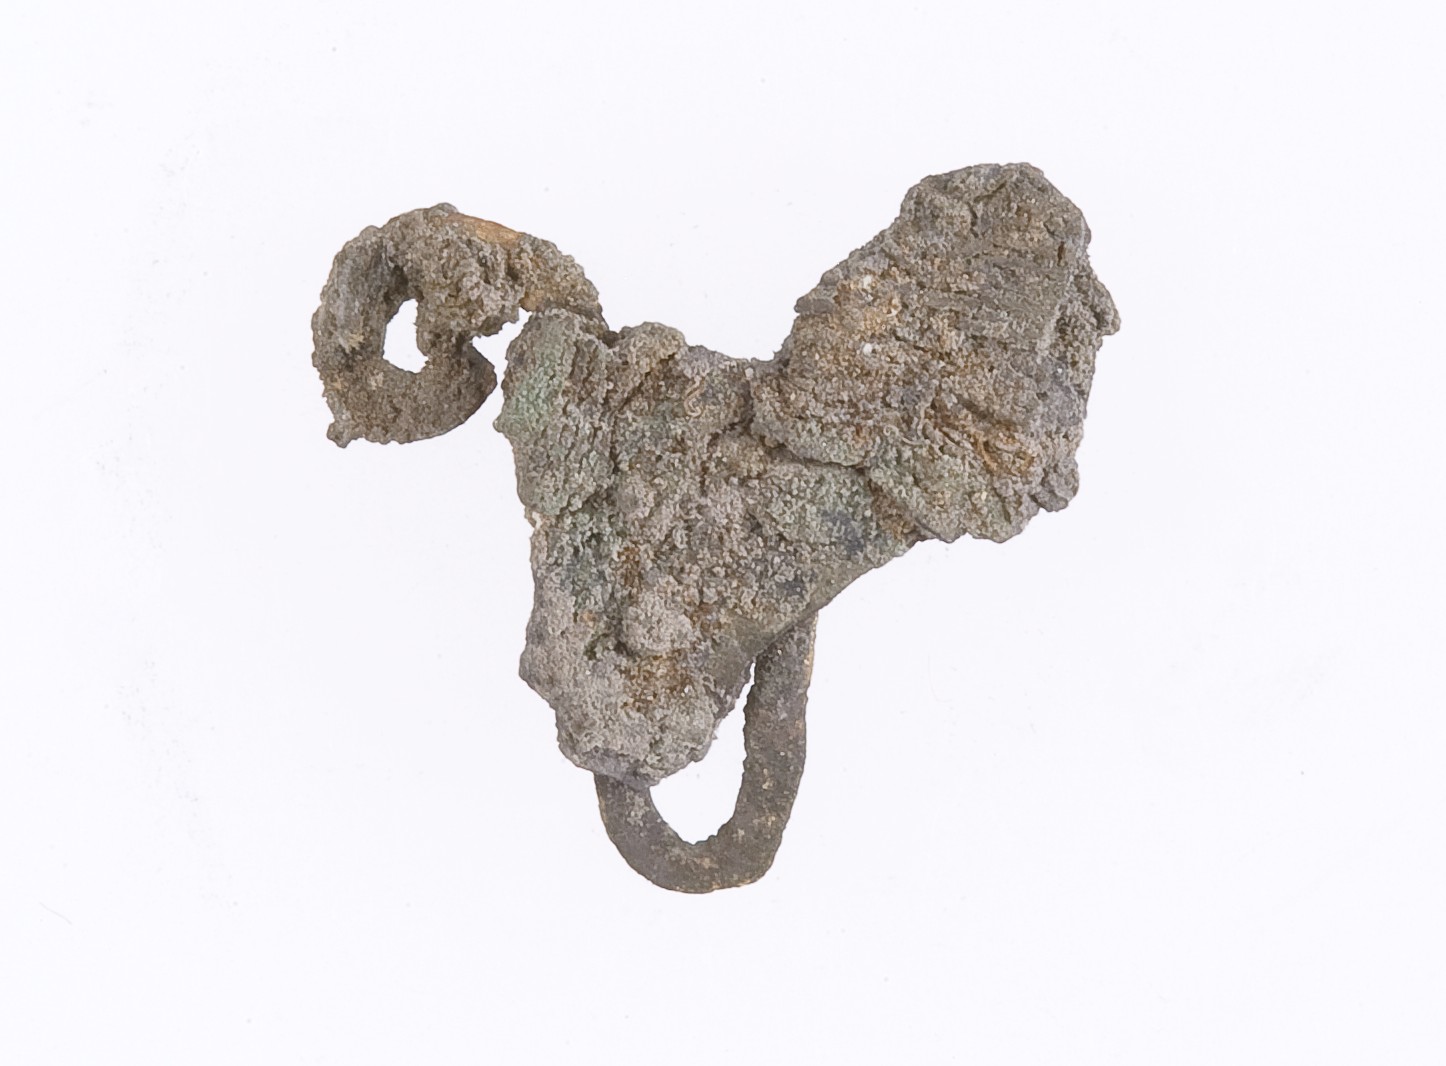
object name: ornament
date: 1981-1640 BCE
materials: gold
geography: egypt